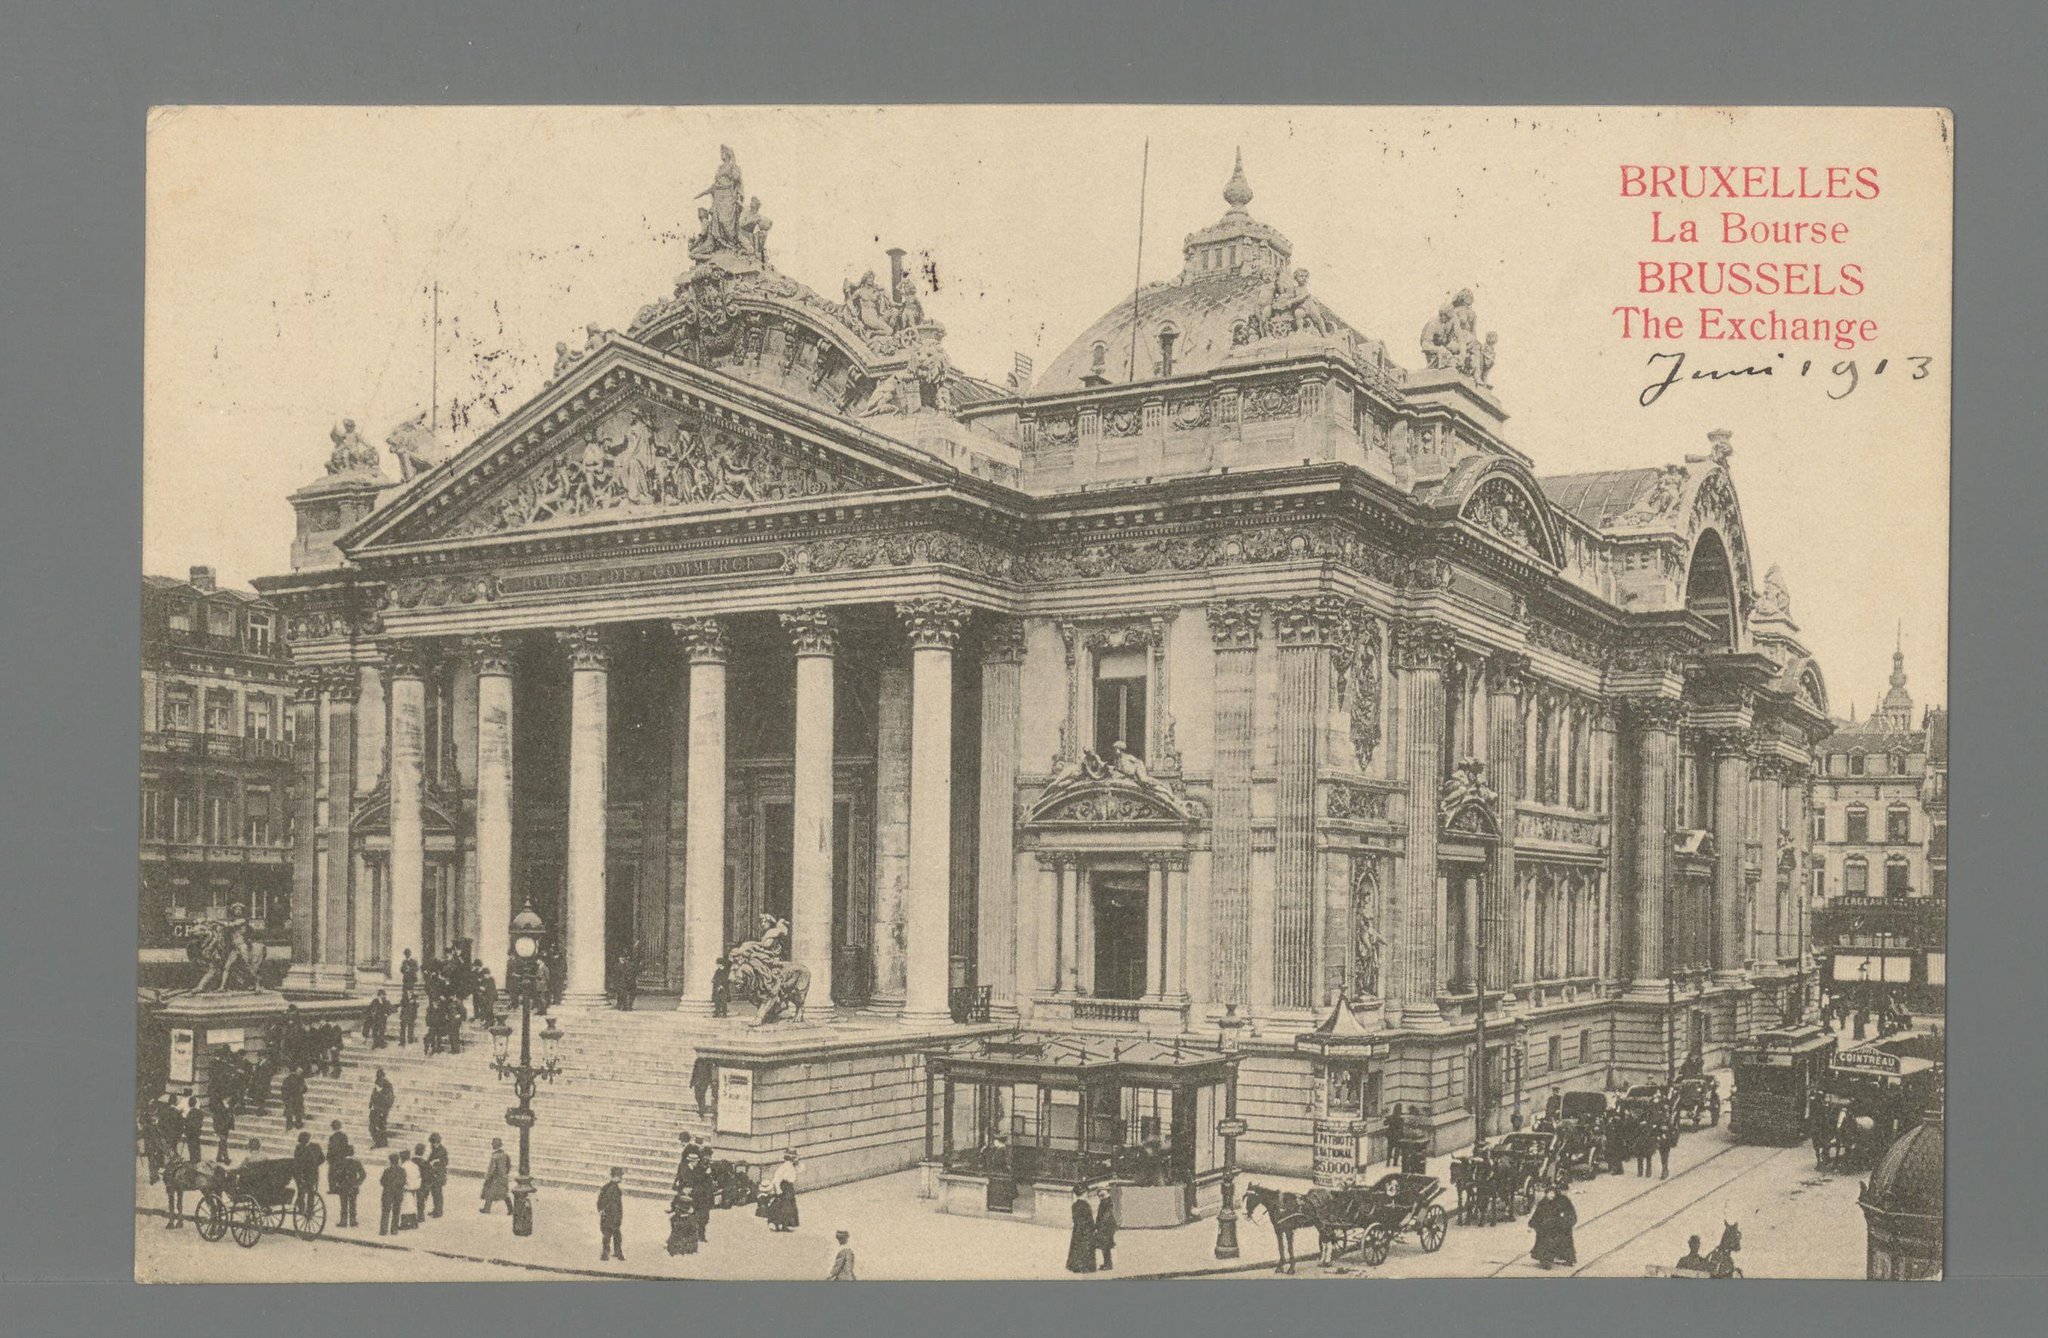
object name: ansichtkaart, prentbriefkaart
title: Bruxelles. La Bourse / Brussels. The Exchange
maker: Anonymous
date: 1906-1913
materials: cardboard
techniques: photograph, writing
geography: brussels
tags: exchange, bourse, city-view, and landscape with man-made constructions (+ city(-scape) with figures, staffage)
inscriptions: postage stamp